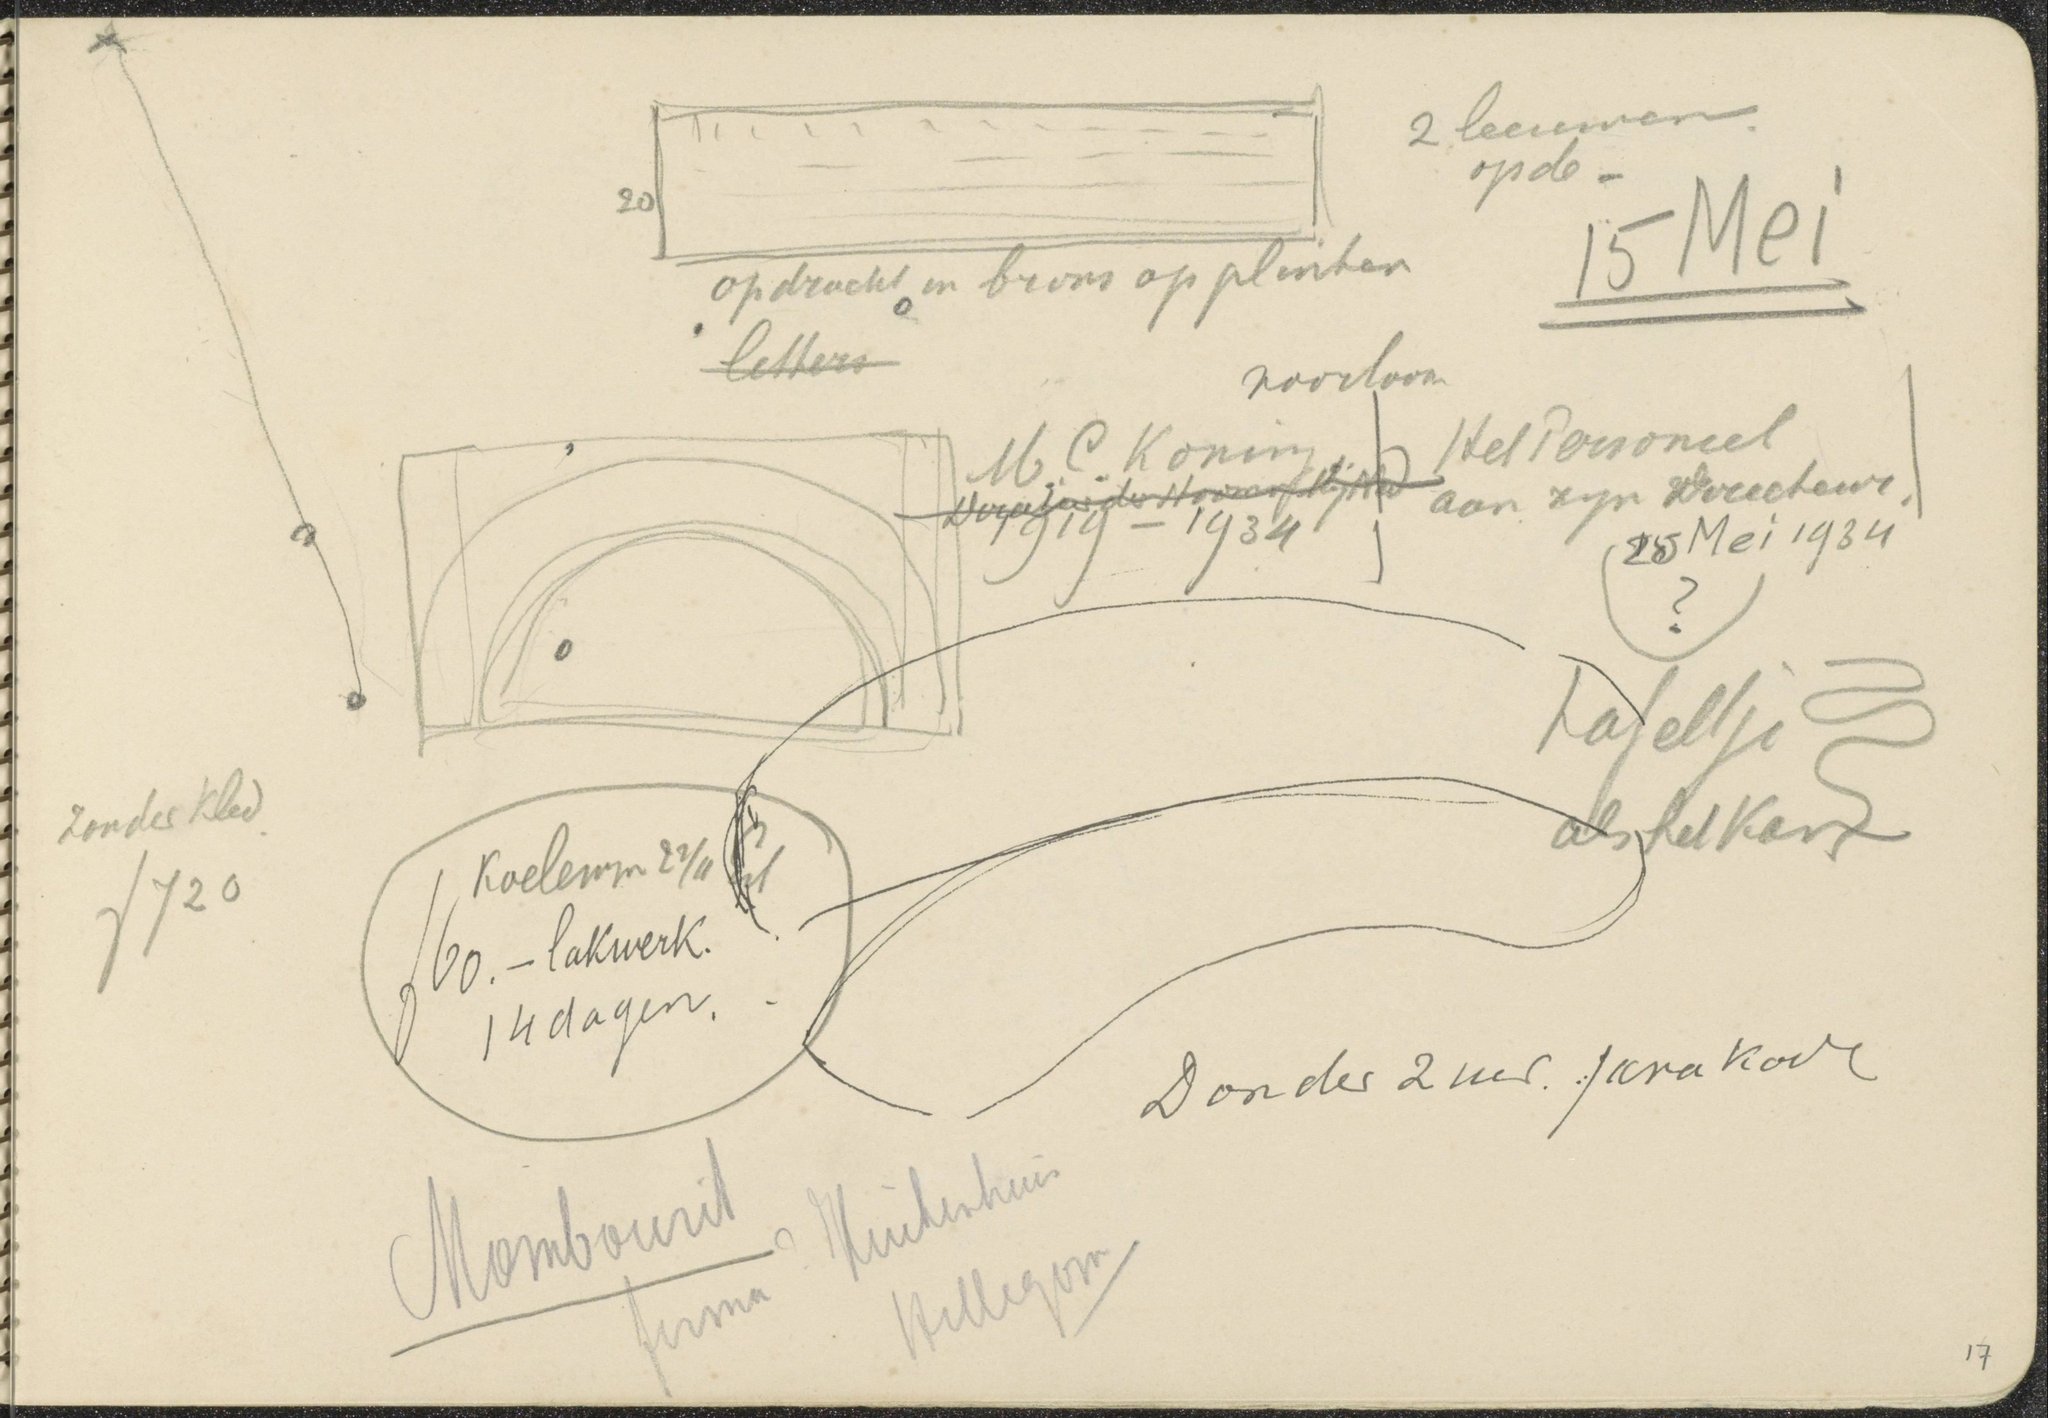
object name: sketchbook leaf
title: Architectuurdetails en een plank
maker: carel adolph lion cachet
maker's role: draughtsman, print maker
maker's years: 1864-1945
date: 1934-1943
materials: ink, paper, pencil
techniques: pen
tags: architectural detail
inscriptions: annotation: ‘[....]’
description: Blad 17 recto uit een schetsboek met 19 bladen.